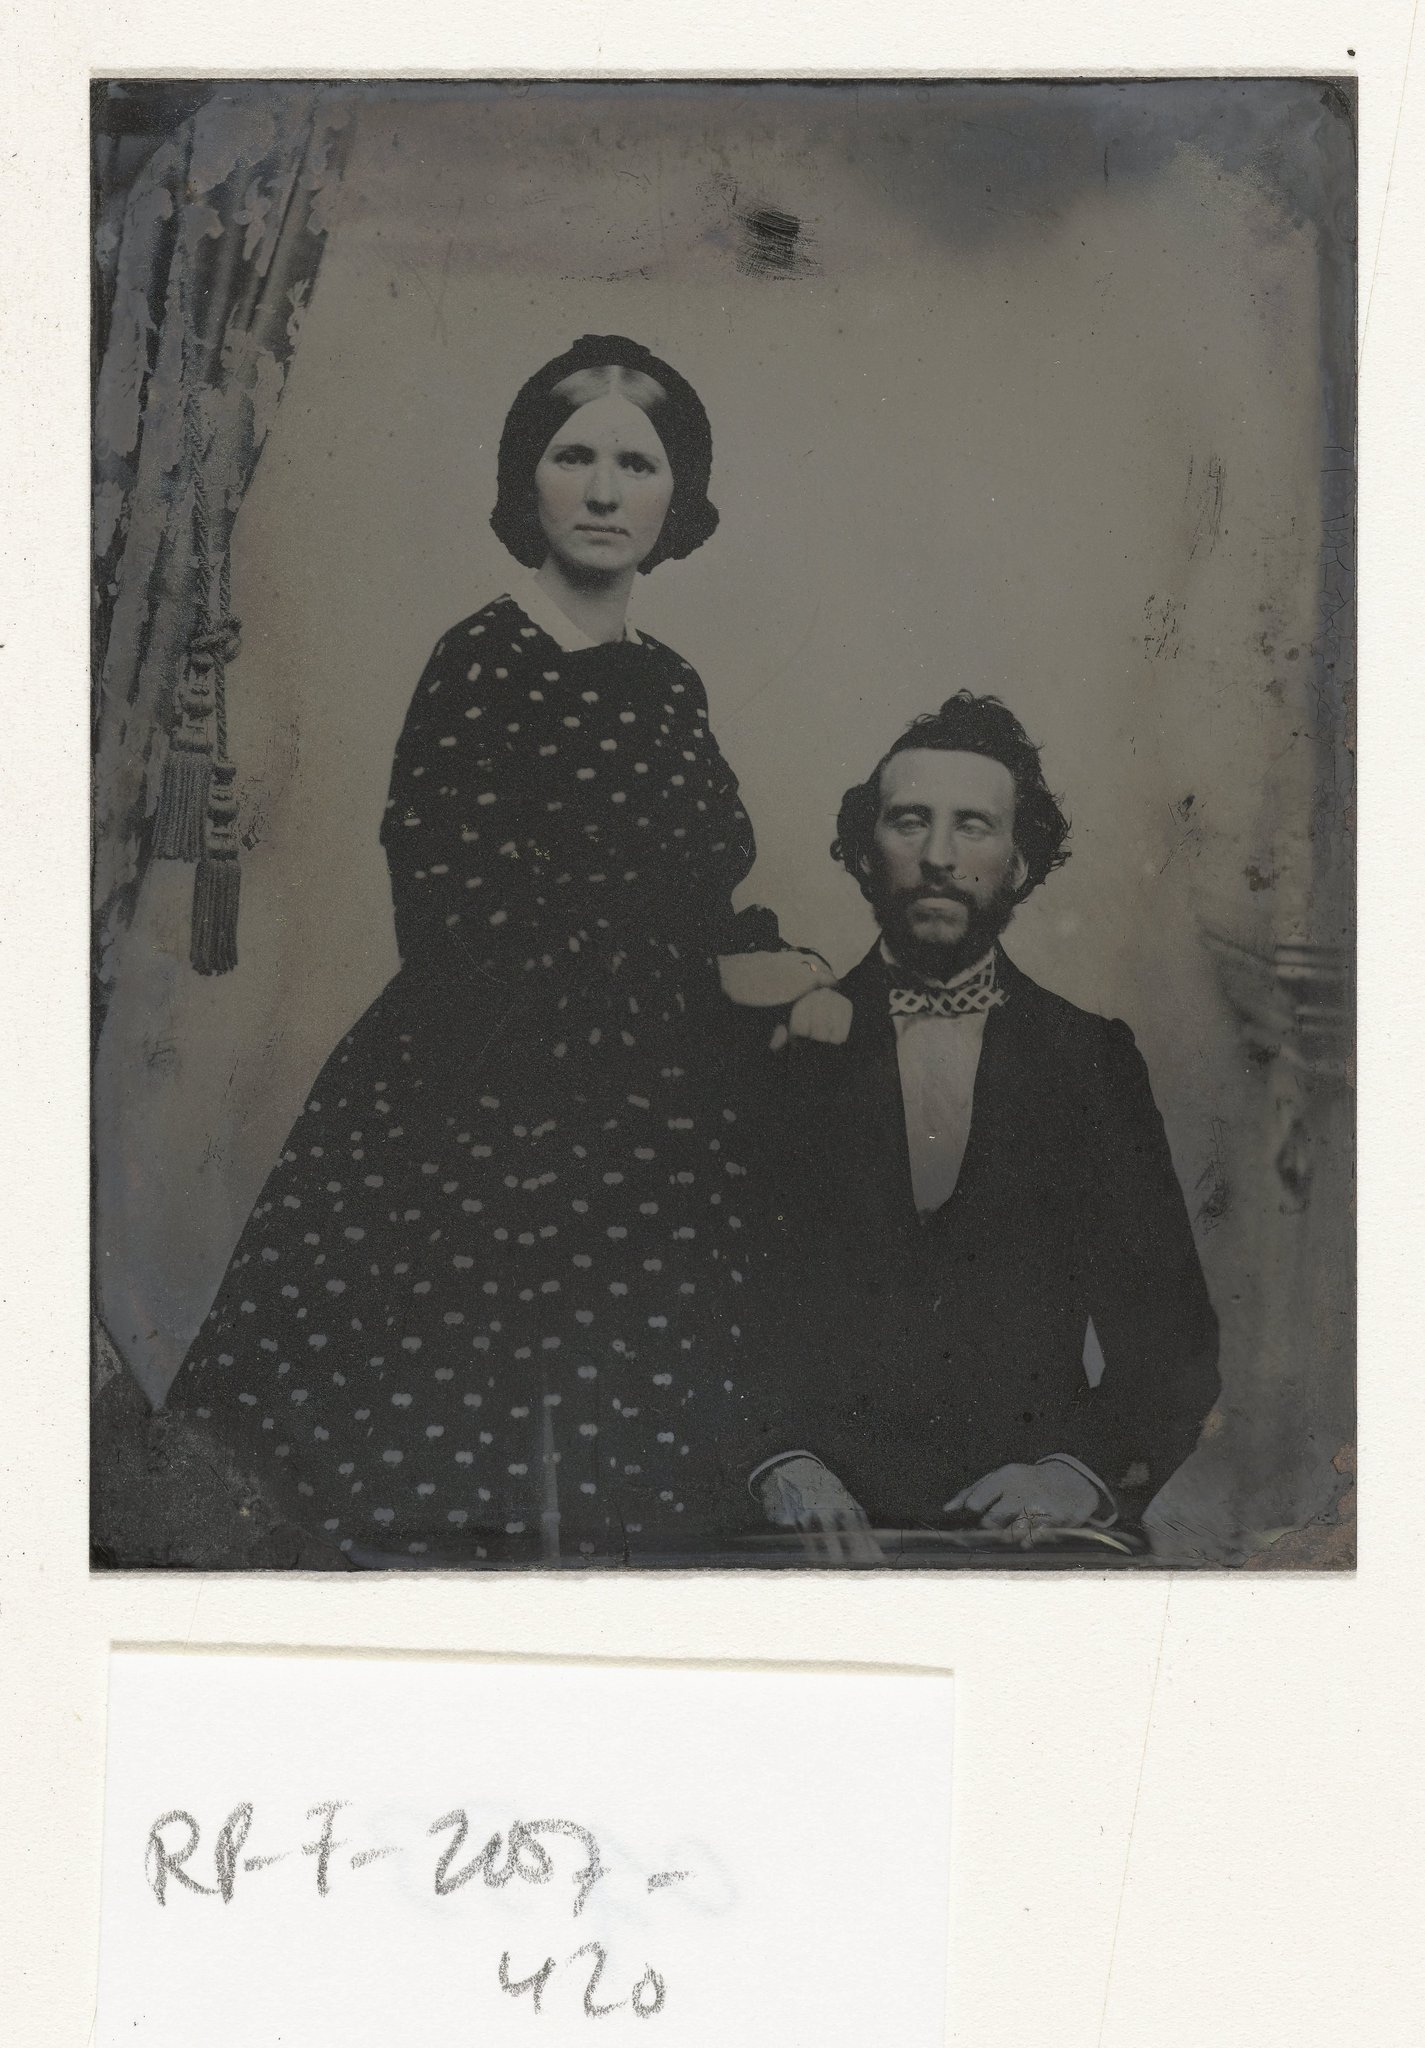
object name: photograph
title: Portrait of a man and a woman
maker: Anonymous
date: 1870-1900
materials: metal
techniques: ferrotyping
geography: united states